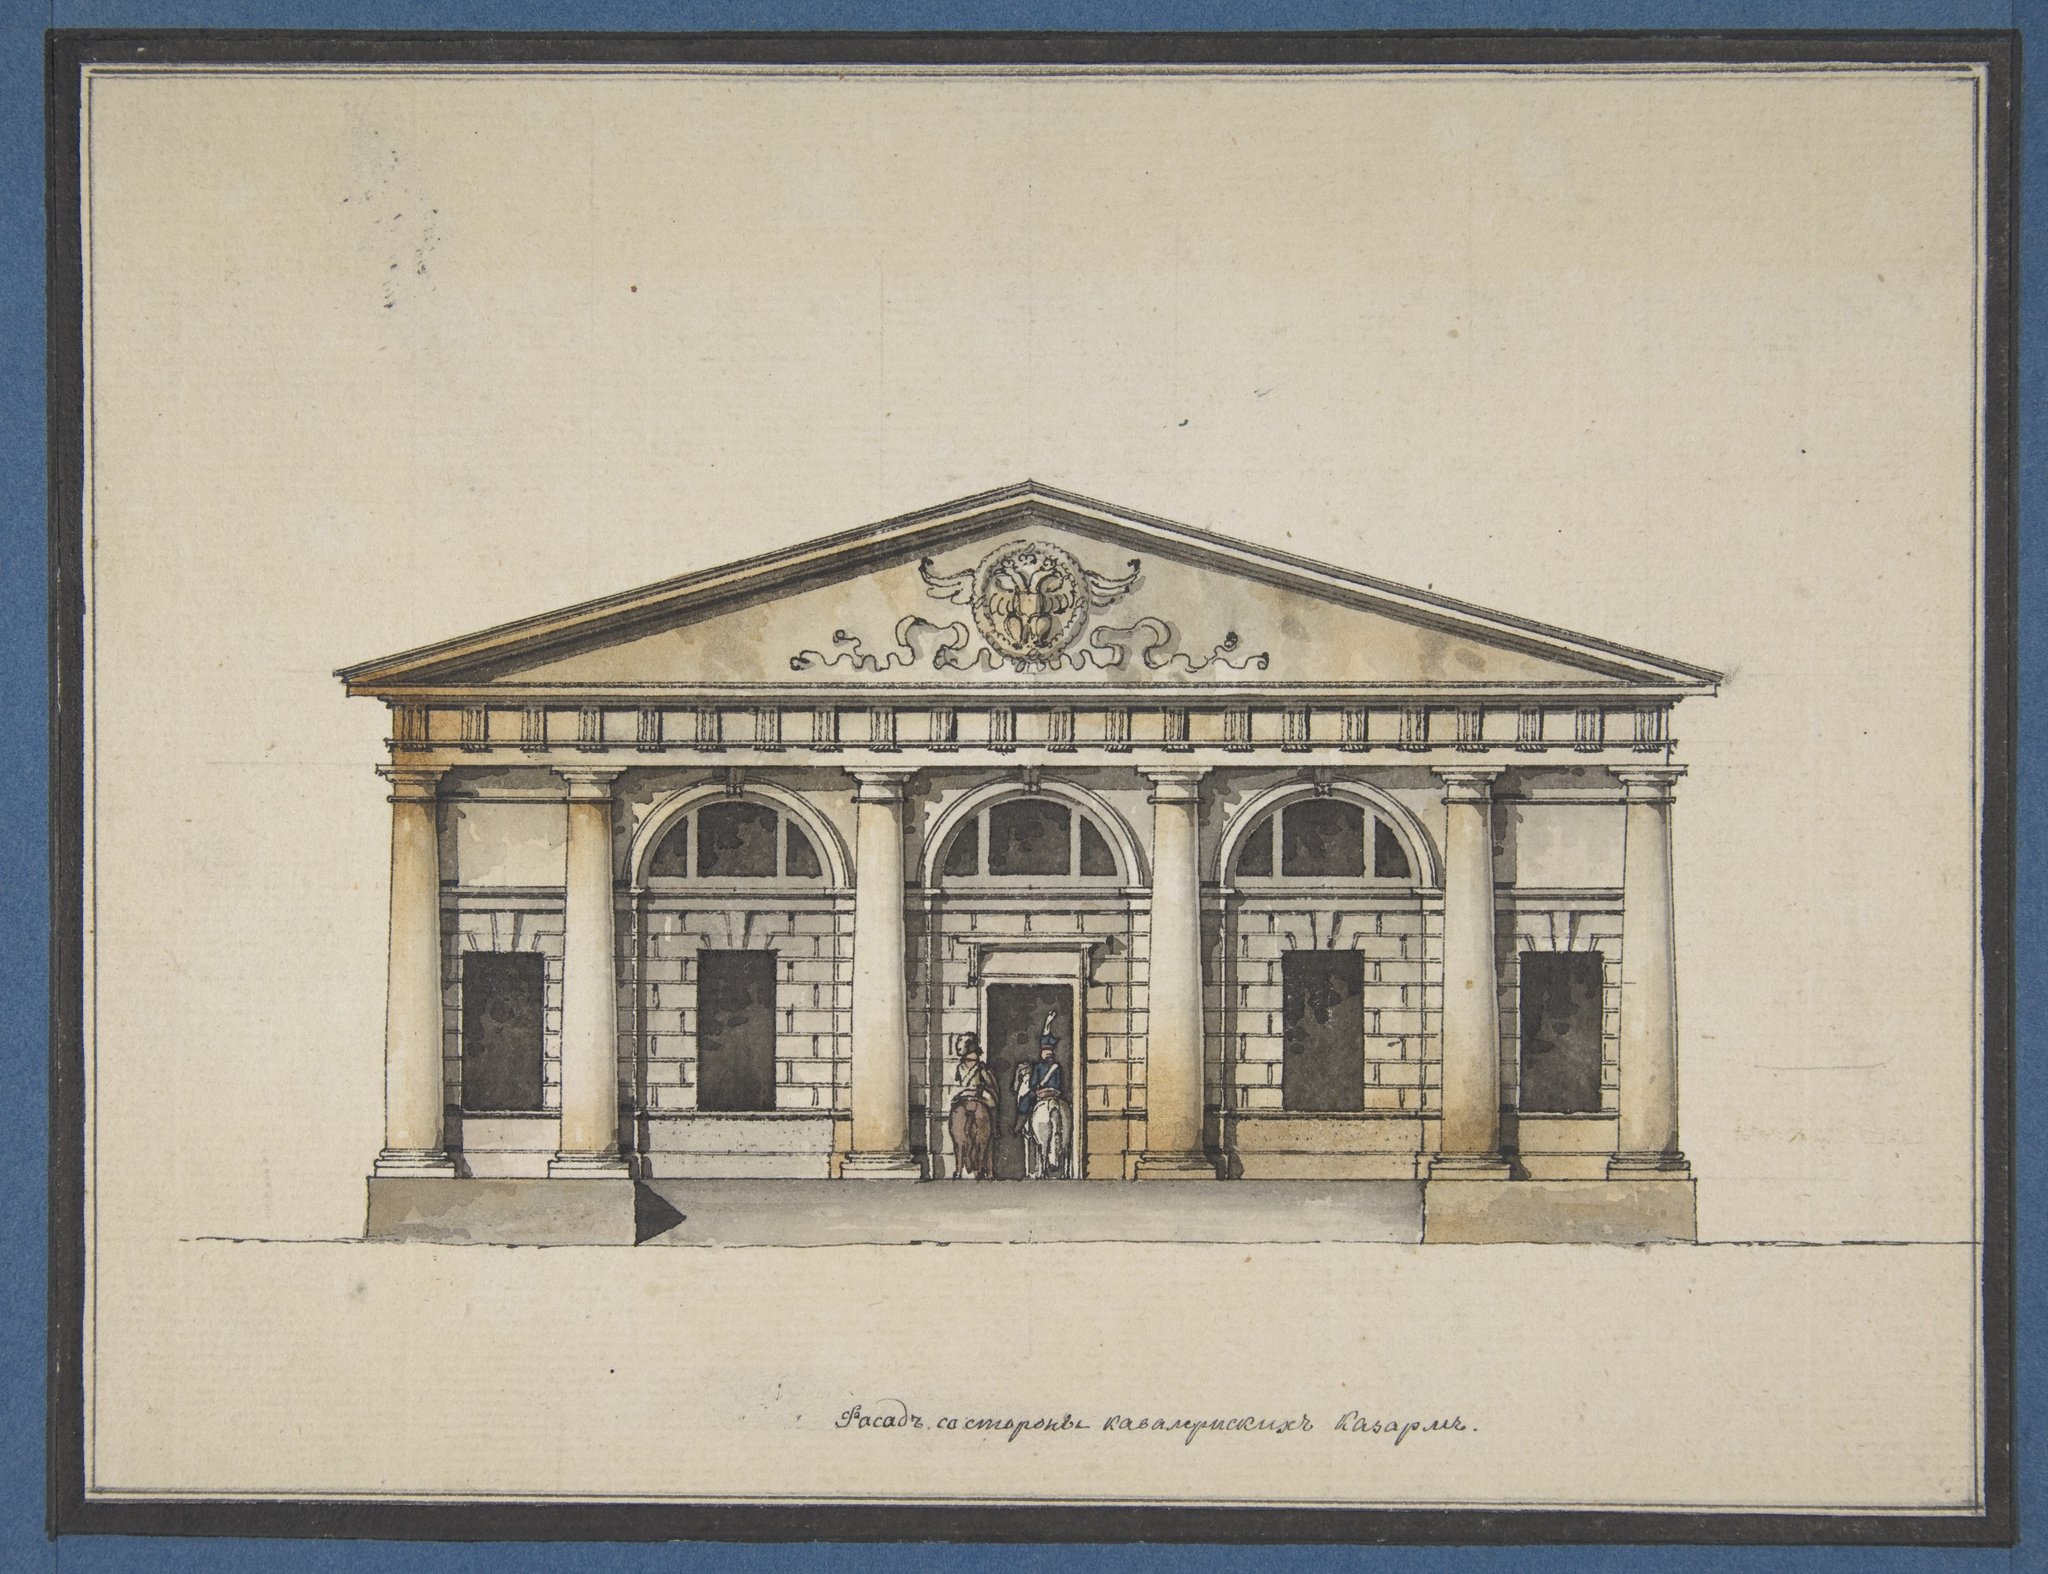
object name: drawing ornament architecture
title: Project for the Riding-School of the Horse Guards in Saint Petersburg - Elevation of the Side Entrance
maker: giacomo quarenghi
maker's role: artist and architect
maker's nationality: italian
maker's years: 1744-1817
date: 1744-1817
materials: graphite, ink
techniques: brush, pen, wash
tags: architecture,schools,horses